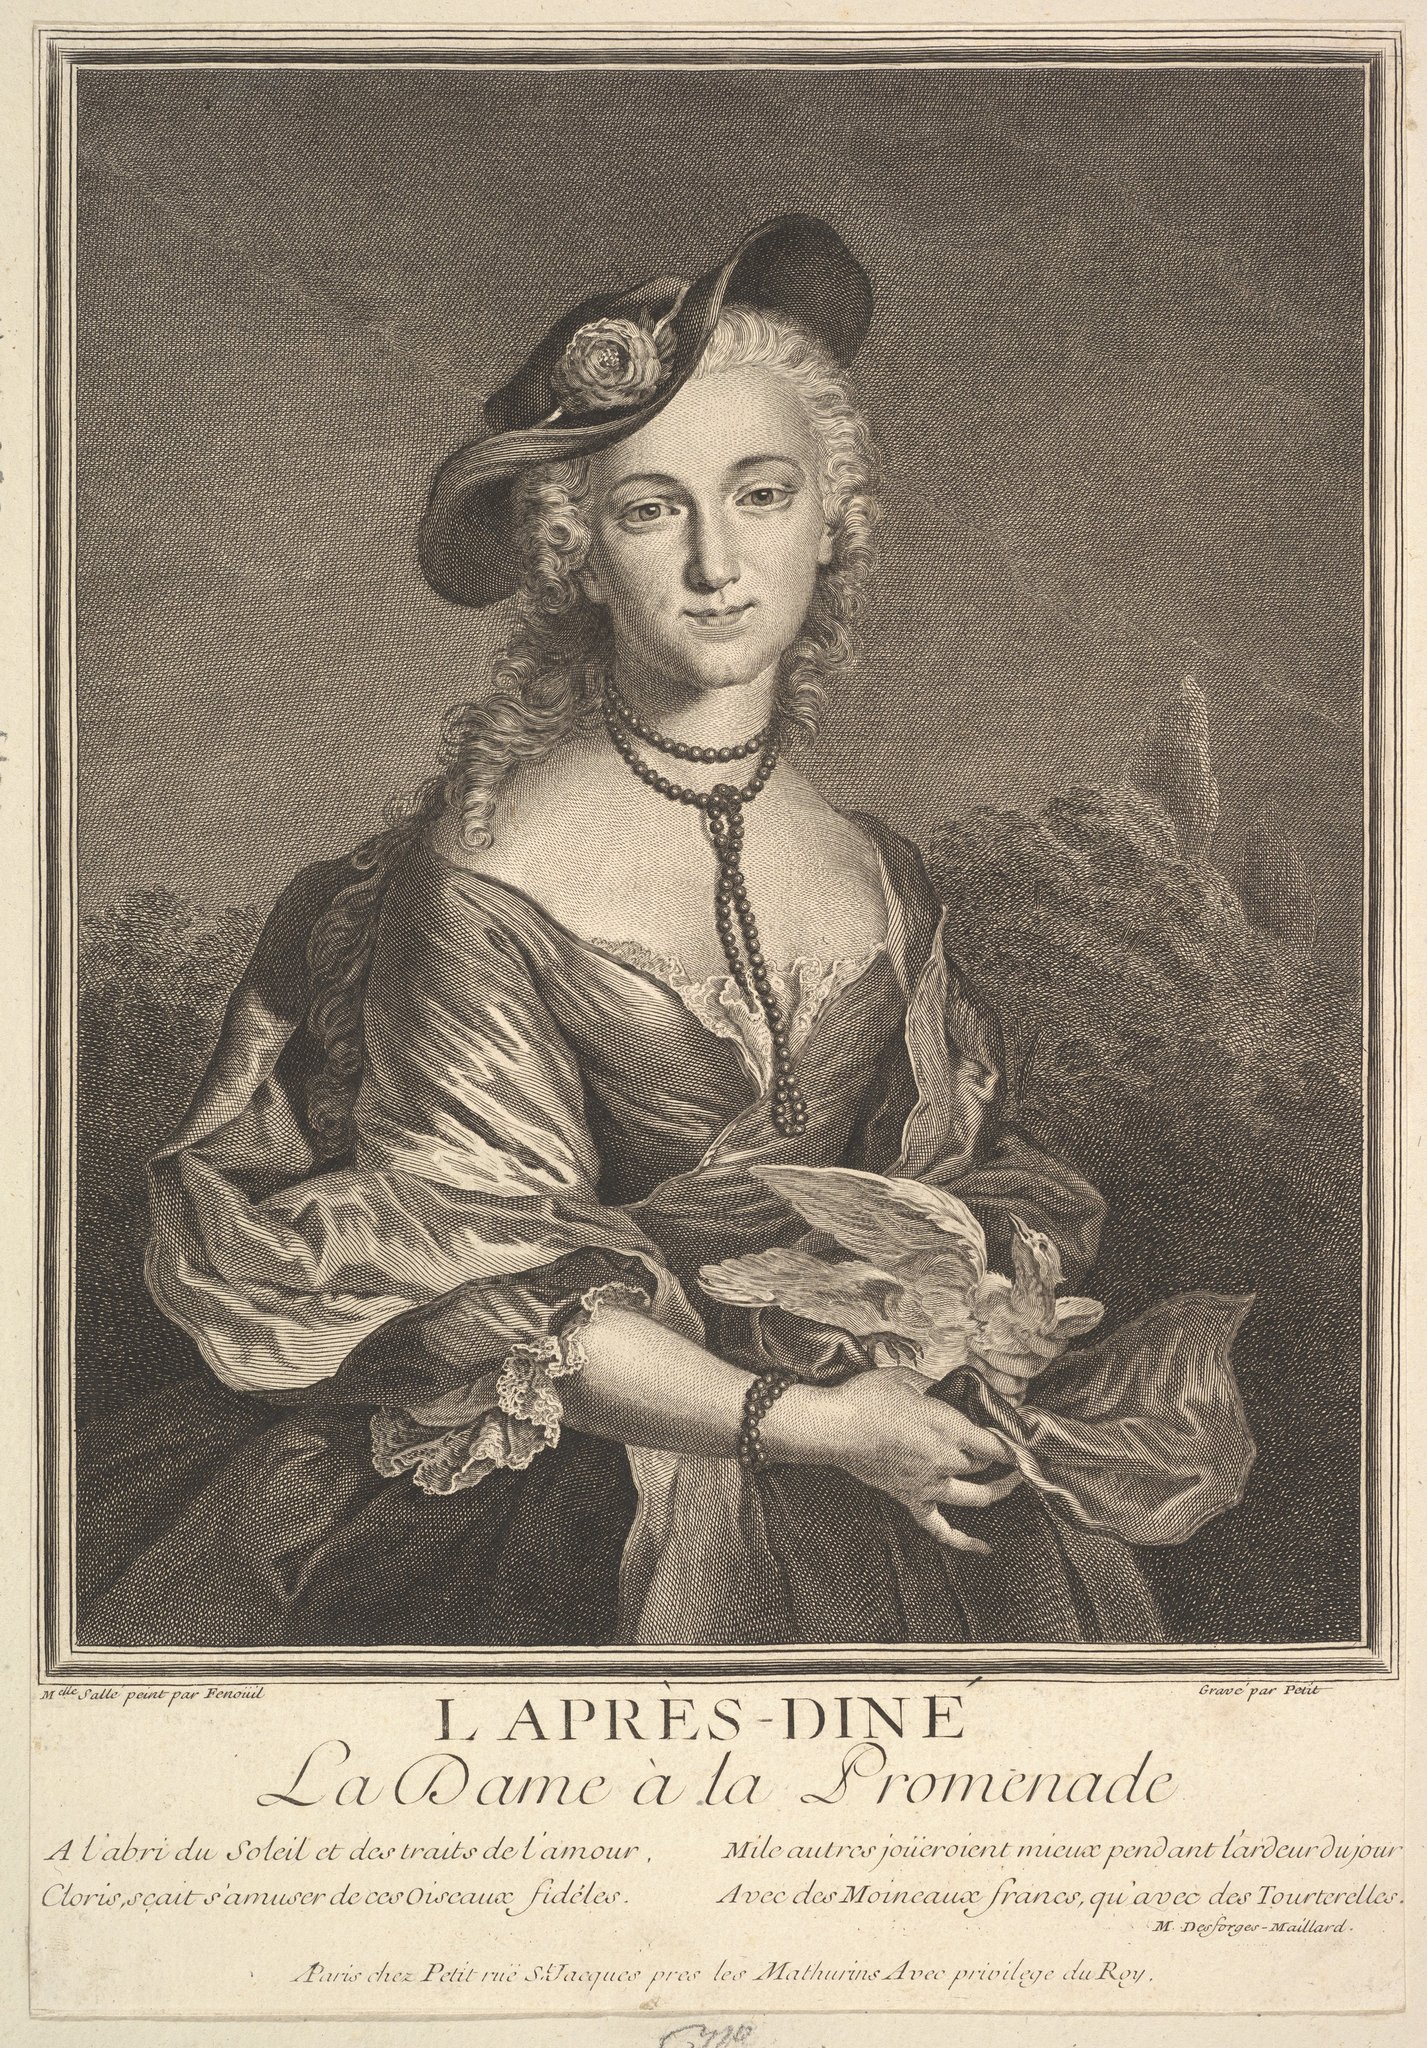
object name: print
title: After-dinner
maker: gilles edme petit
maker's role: artist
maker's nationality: french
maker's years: 1694-1760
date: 1694-1760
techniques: engraving, etching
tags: birds,portraits,women